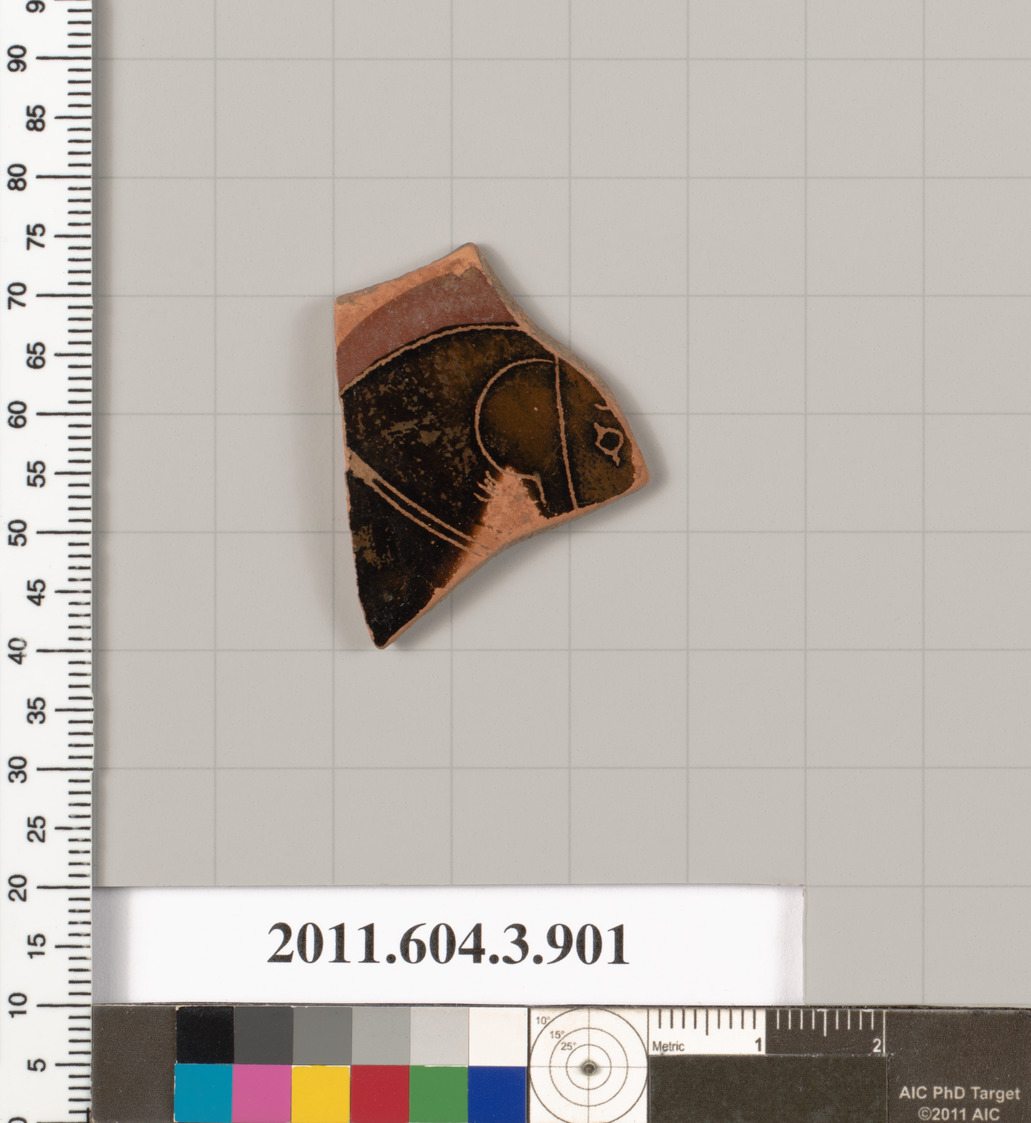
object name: lekythos fragment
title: Terracotta fragment of a lekythos (oil flask)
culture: greek, attic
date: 534-501 BCE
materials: terracotta